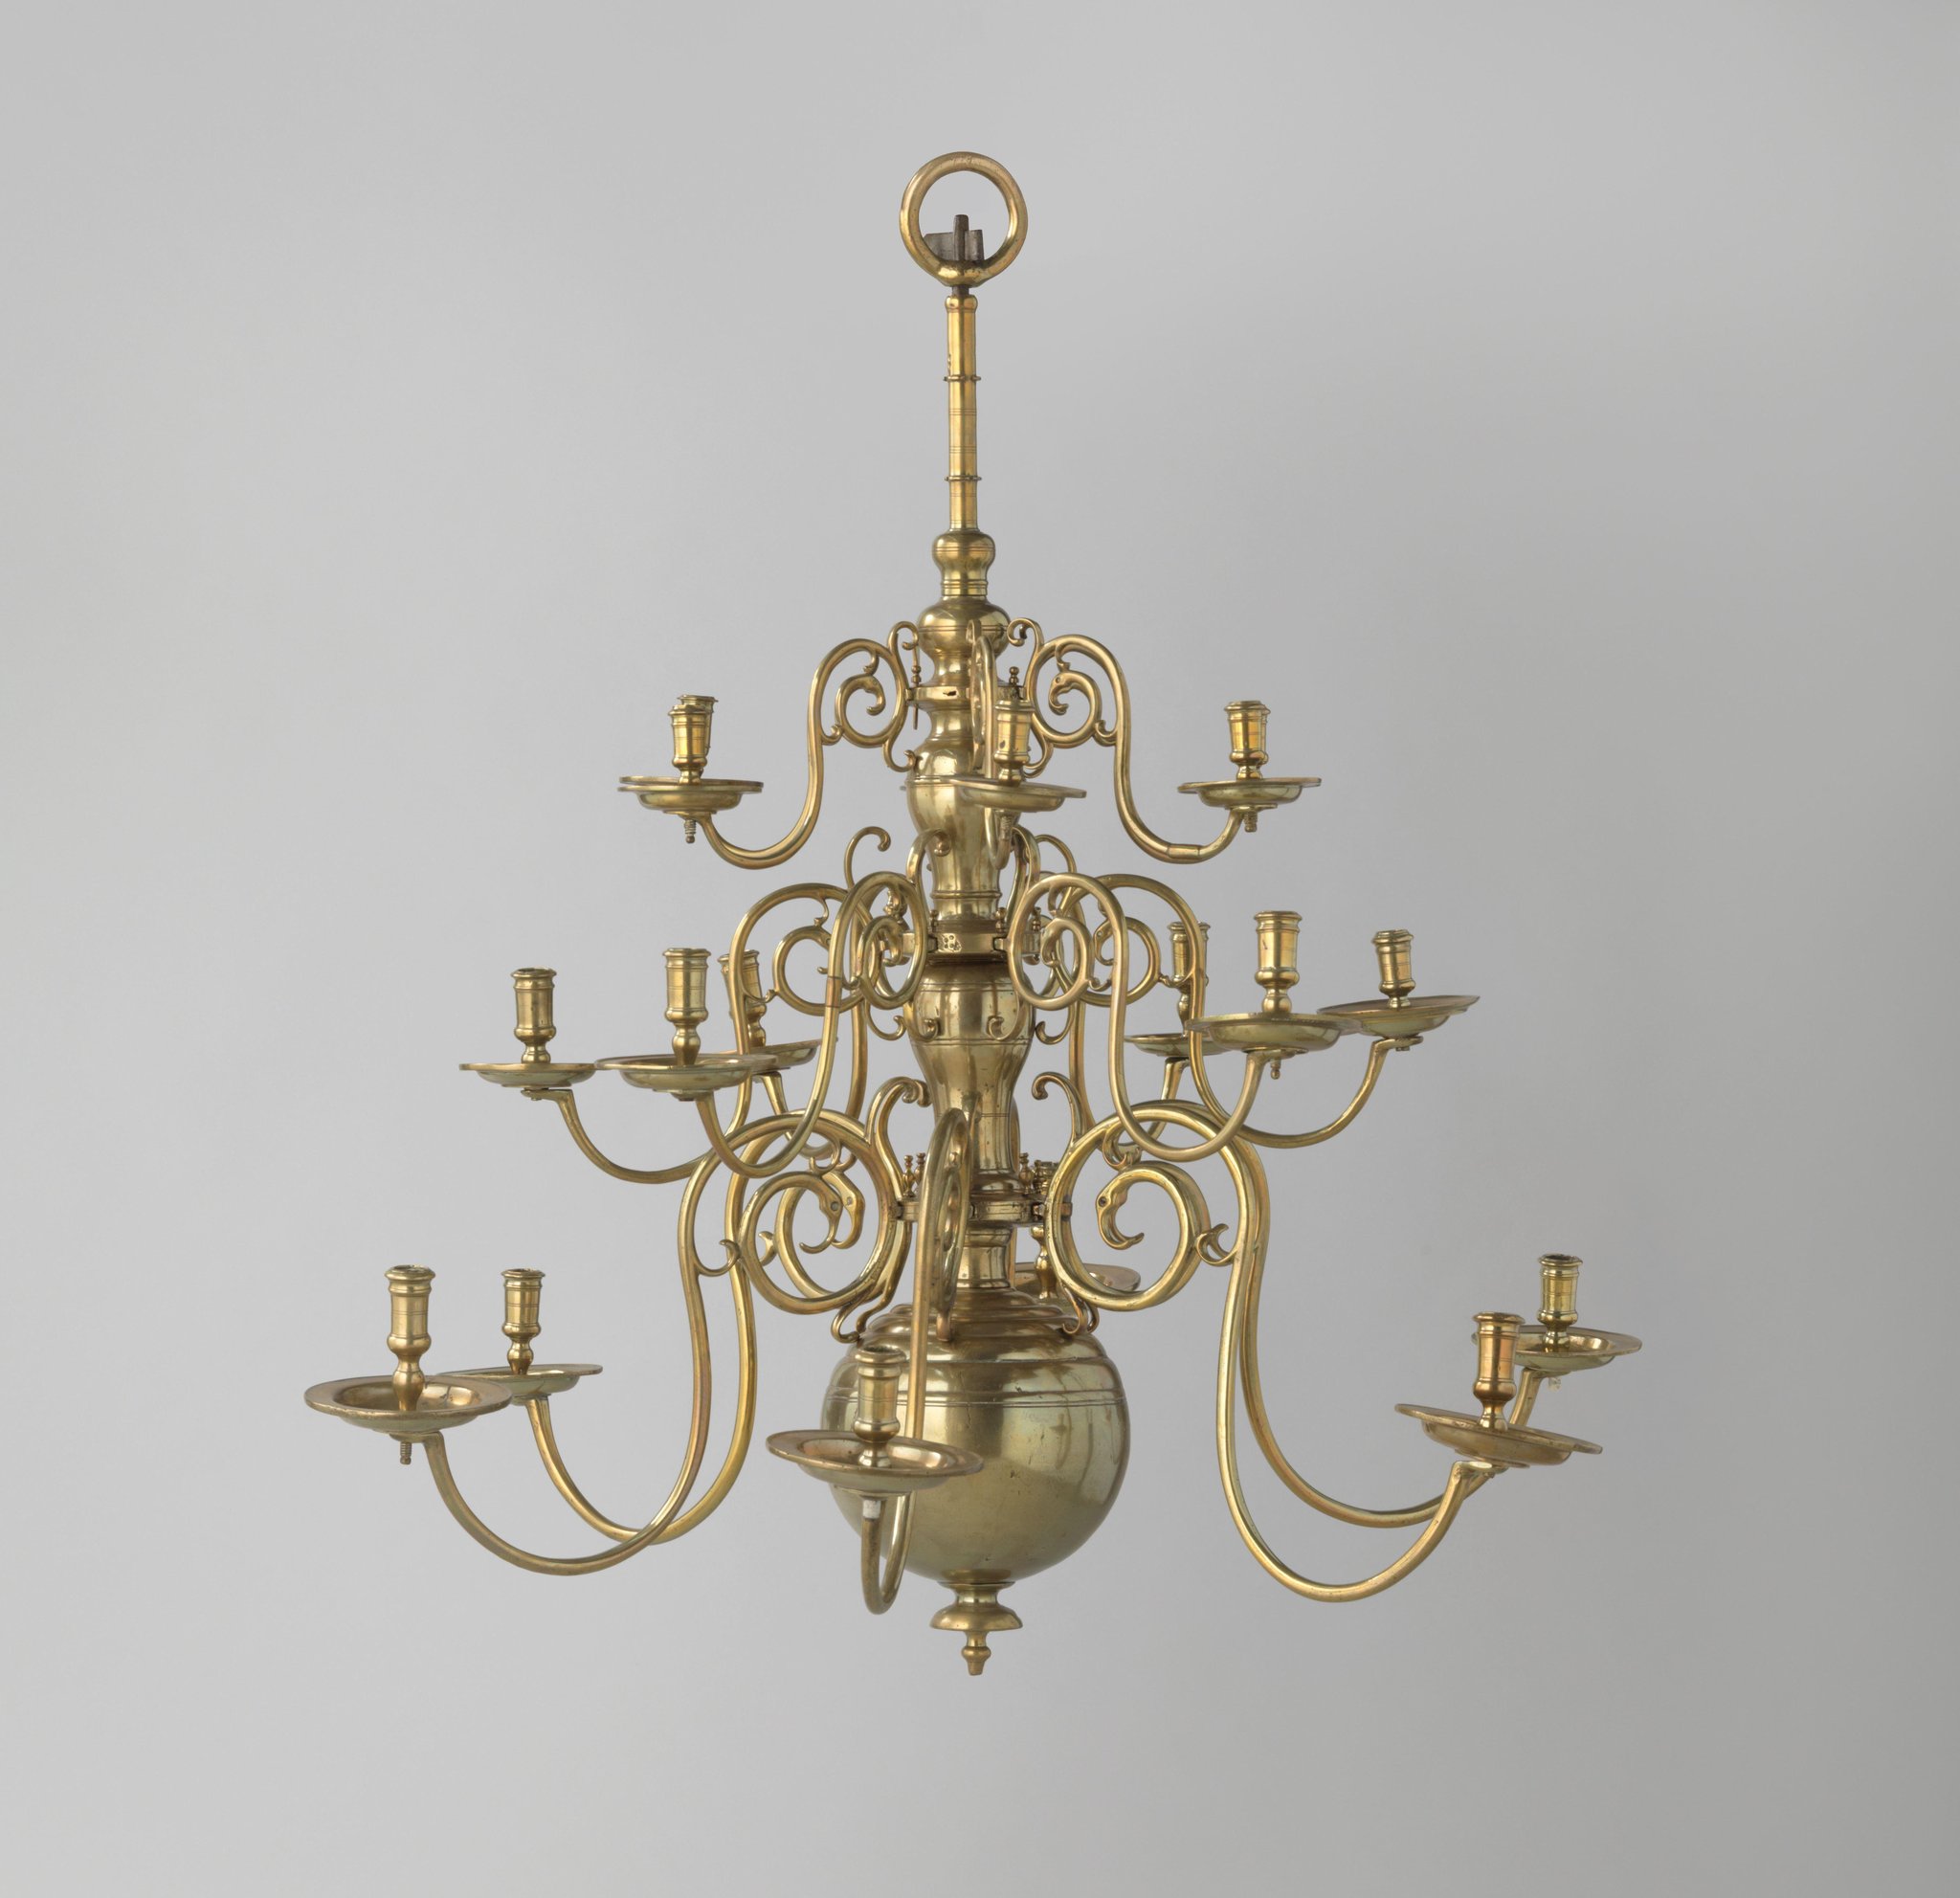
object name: chandelier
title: Arm met kaarsenhouder van kaarsenkroon van drie hoogten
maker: Anonymous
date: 1675-1725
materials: brass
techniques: casting, screwed, turning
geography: southern netherlands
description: Kaarsenarm behorende bij een messing kaarsenkroon van drie hoogten. De S-vormige arm heeft een krul en gaat naar buiten toe over in het platte verdikking met een schroefgat. Daarin is de kaarsenhouder met de vetvanger vastgezet. De vetvanger is aan de onderzijde geribd geprofileerd rond de opening en heeft verder twee maal twee gegroefde ringen. De cylindrische kaarsenhouder, die een geprofileerde uitstekende rand, twee gegroefde ringen en een verdikking onderaan heeft, gaat over in een baluster met onderaan het eind met schroefdraad en een knopje, waarin het centergat te zien is. Dit is de eerste arm van de onderste standring, genummerd met 1 ronde punt. De pin, om de arm aan de standring te bevestigen, heeft een balustervorm.